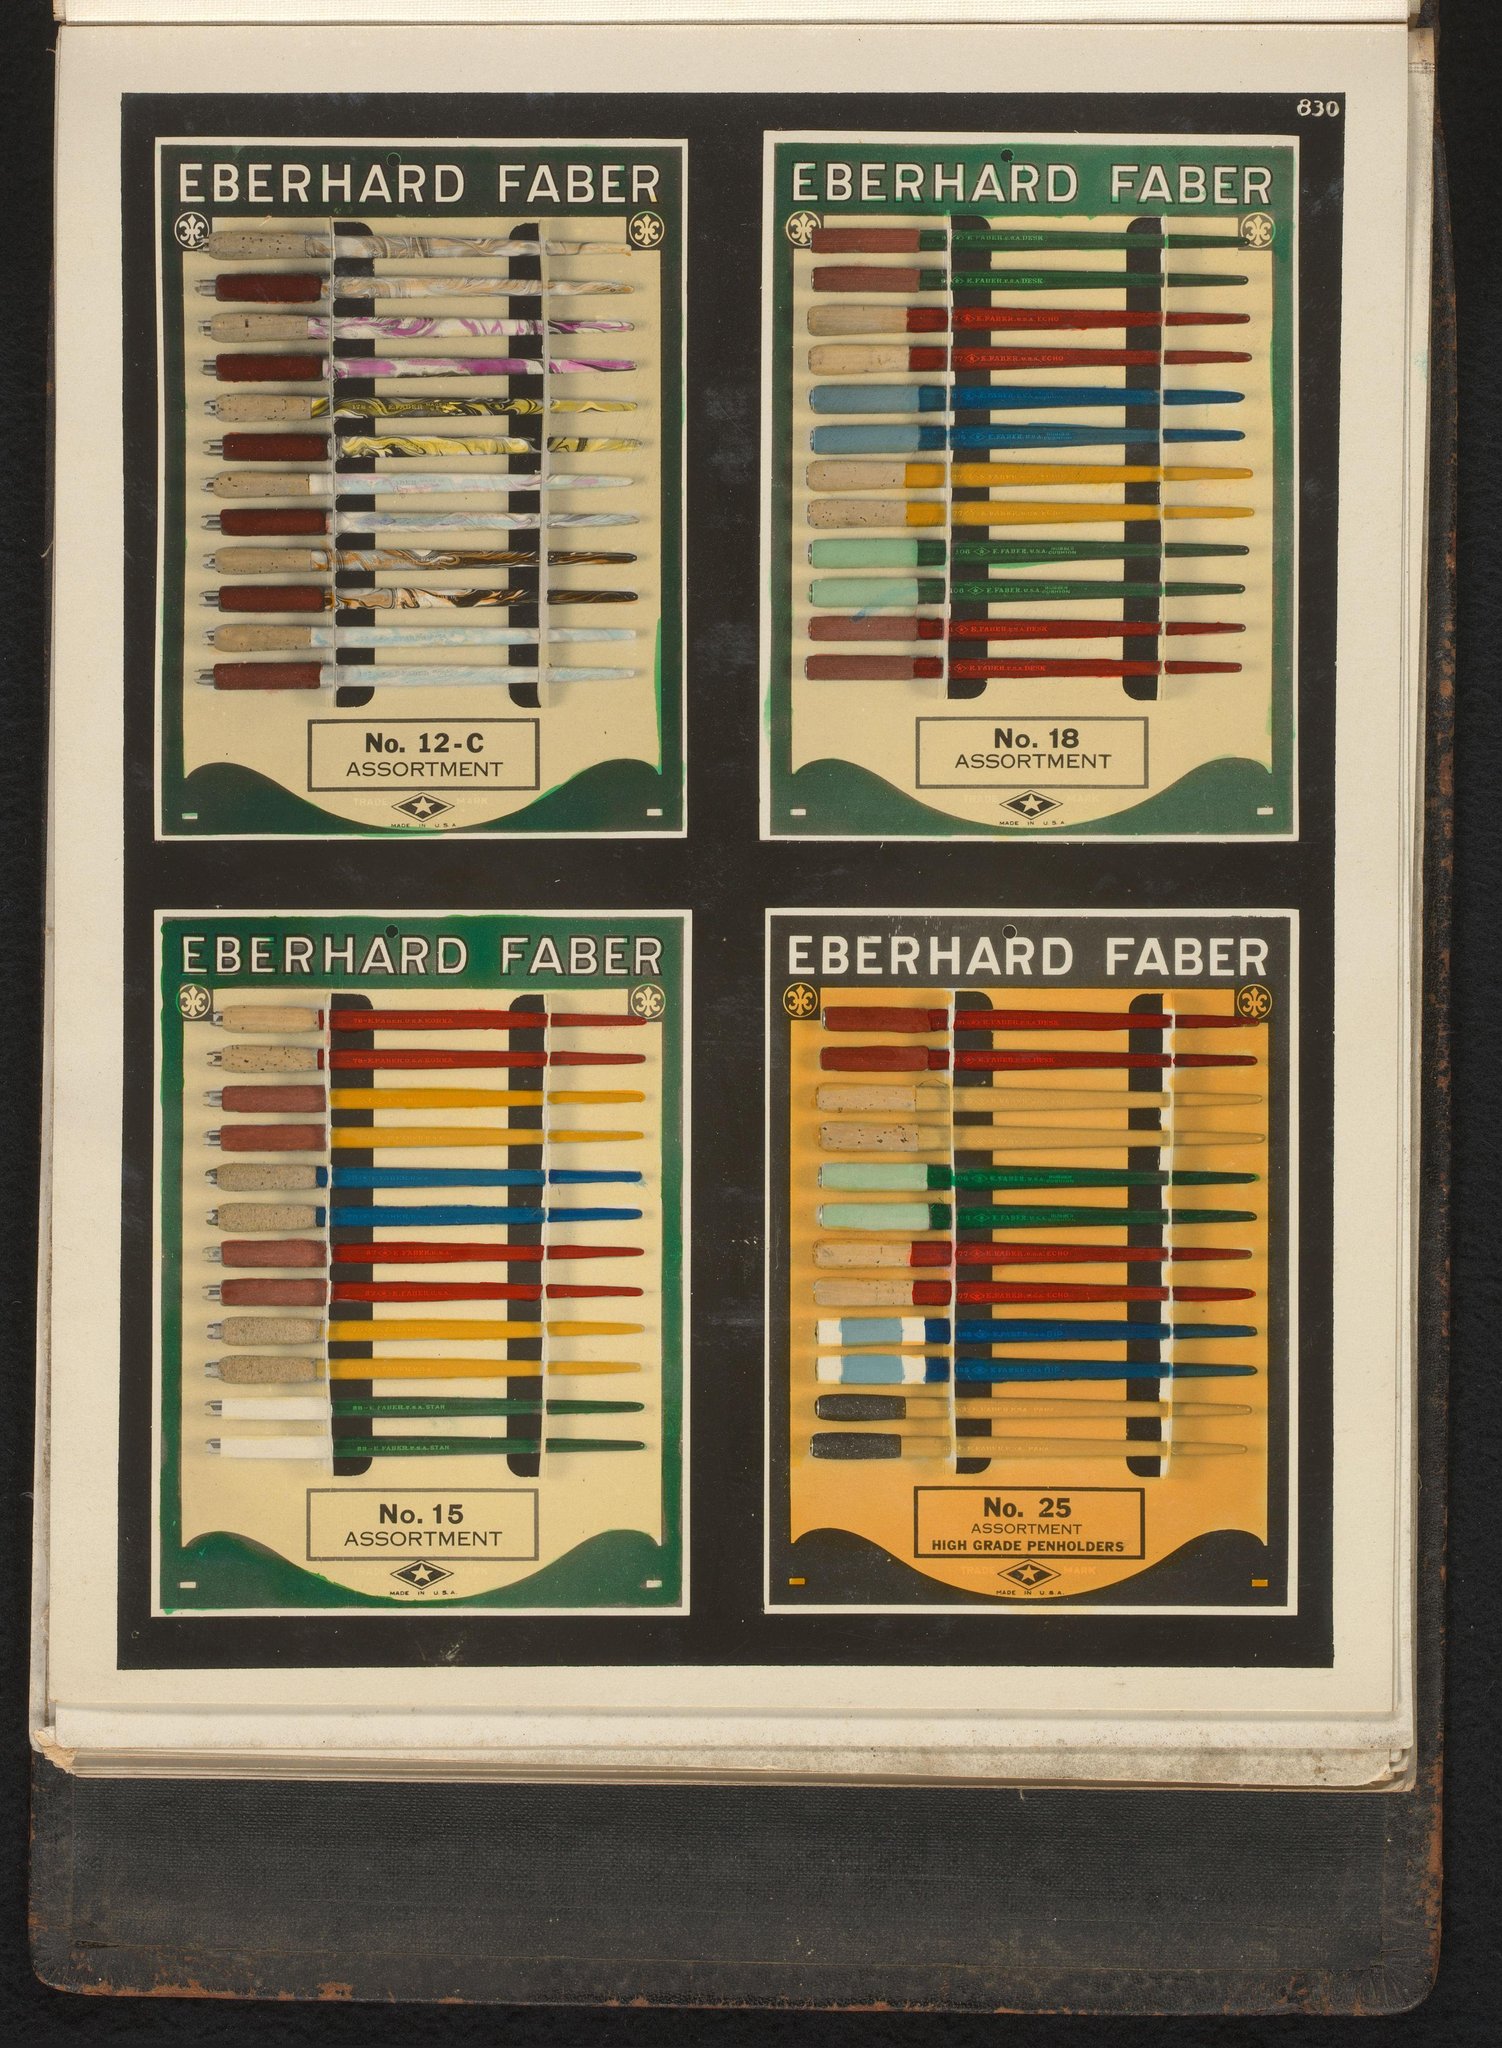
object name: photograph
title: Standaarden met pennen van Eberhard Faber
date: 1915-1935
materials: paper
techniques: gelatin silver print, hand coloring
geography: springfield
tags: pen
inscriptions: number: ‘830’, stamp: ‘Paramount/ Commercial Studios/ 145 Chestnut St./ Springfield - Mass.’